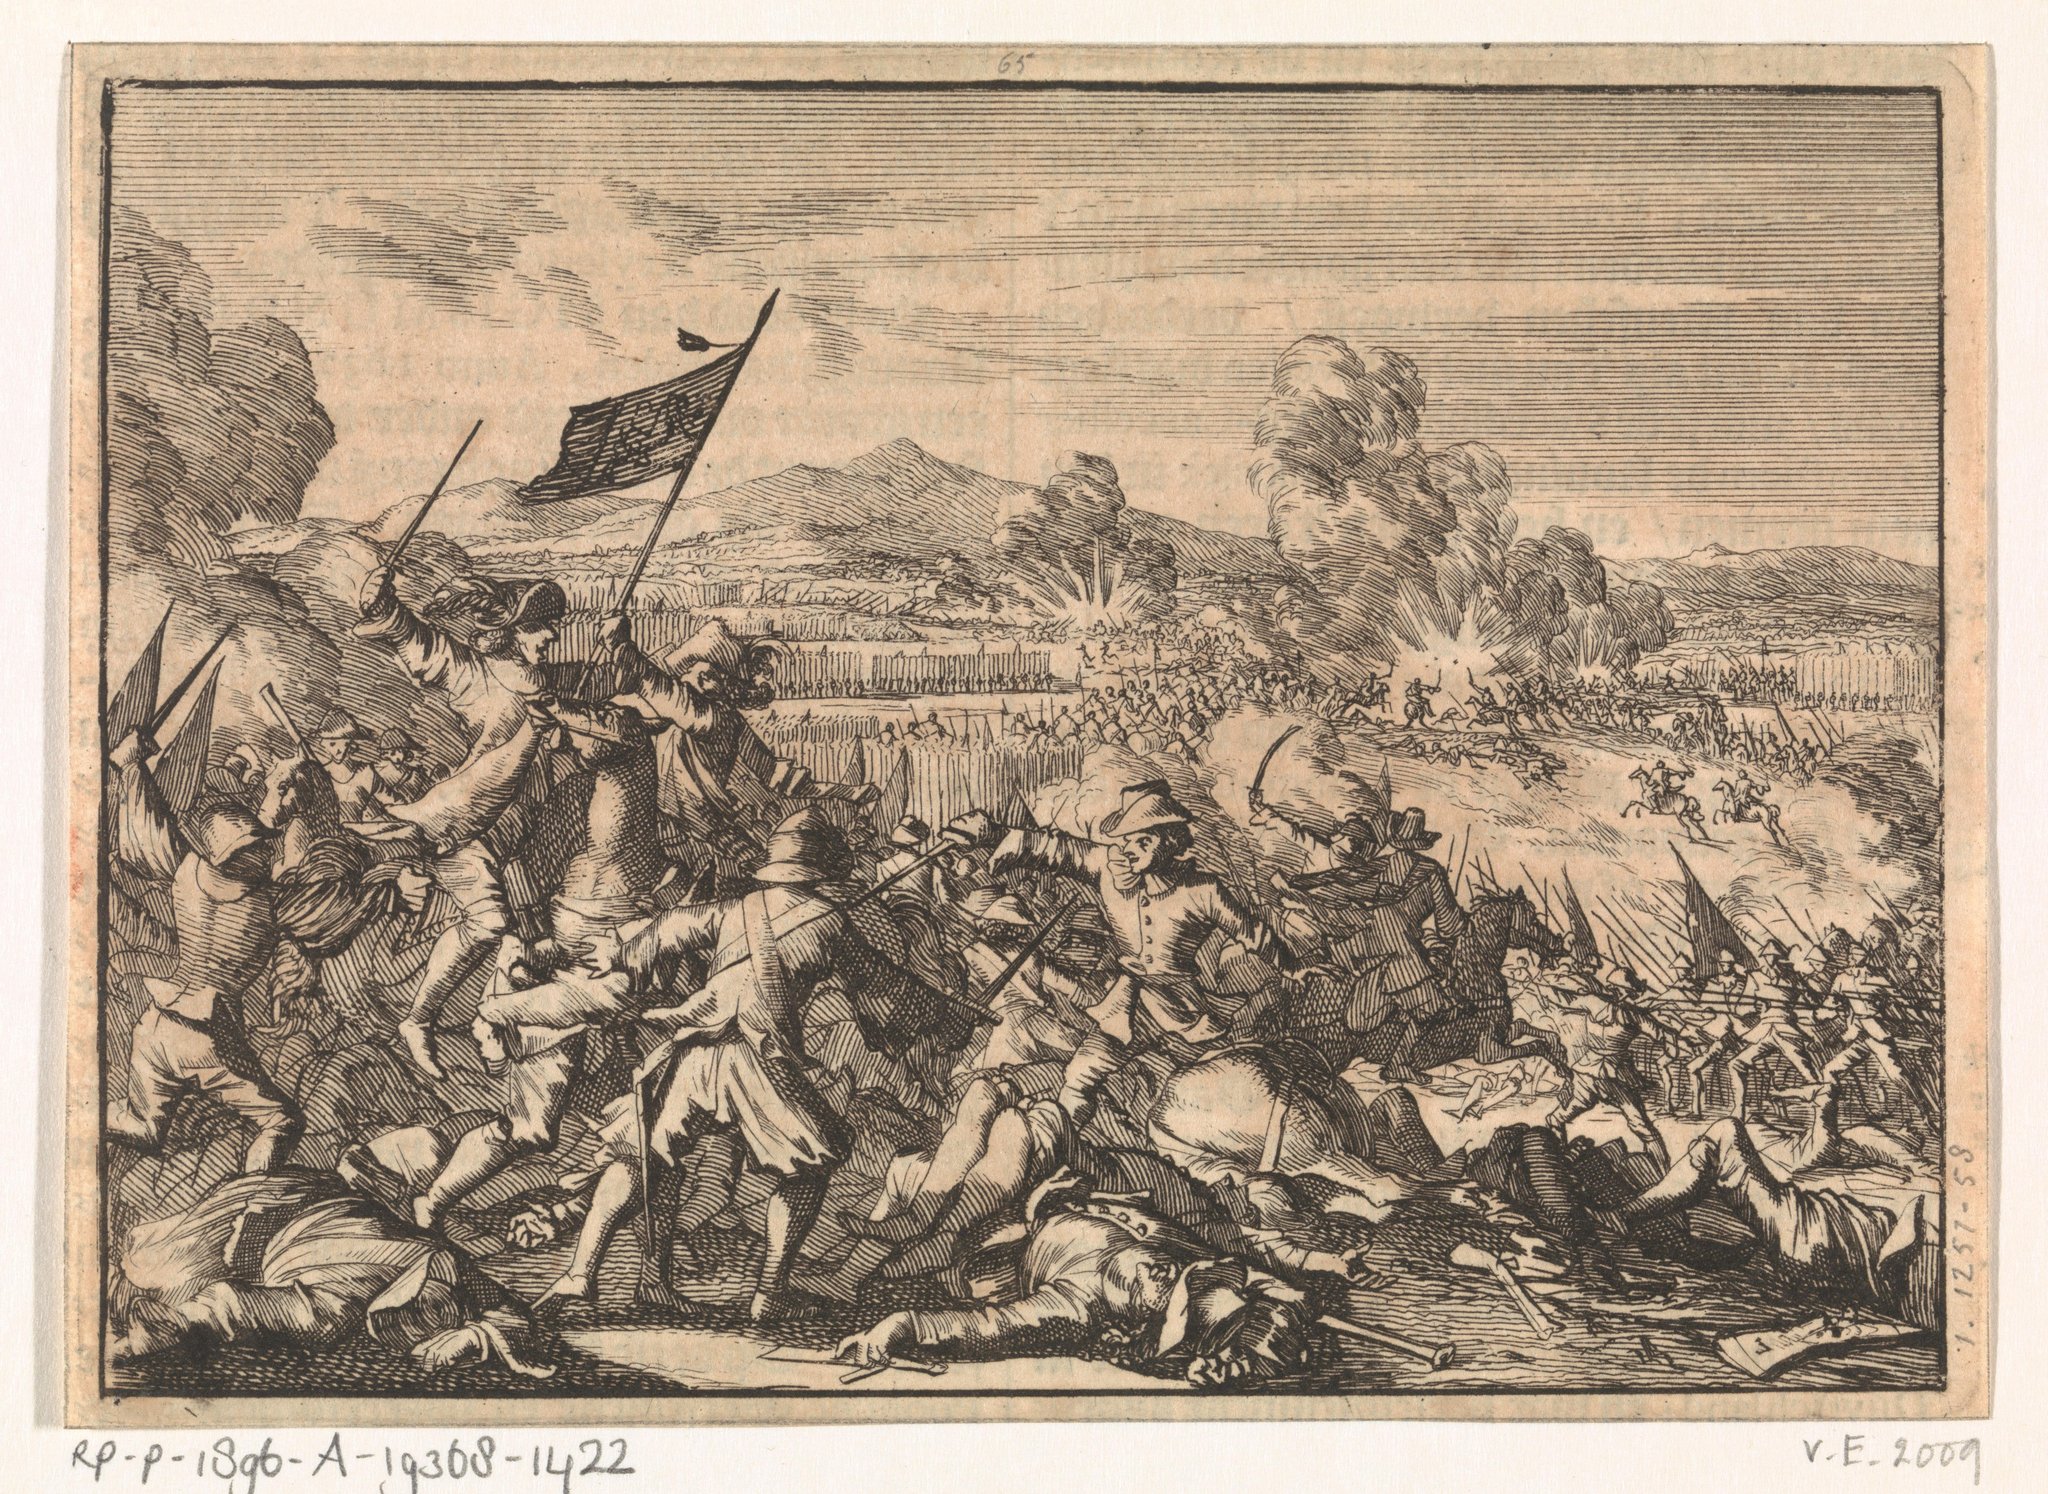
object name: book illustration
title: Overwinning der Zweden op het leger van de keizer bij Wittstock, 1636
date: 1698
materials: paper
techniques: etching, letterpress printing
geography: leiden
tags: siege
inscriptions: collector's mark: Lugt 2228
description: Illustratie uit: Gottfried, Johann Ludwig. Historische kronyck; vervattende een (...) beschrijvingh der aldergedenckwaerdigste geschiedenissen des weerelds, van den aenvangh der scheppingh tot (...) 1576 (2 delen). Leiden: Pieter van der Aa, 1698, dl. I, p. 1257.